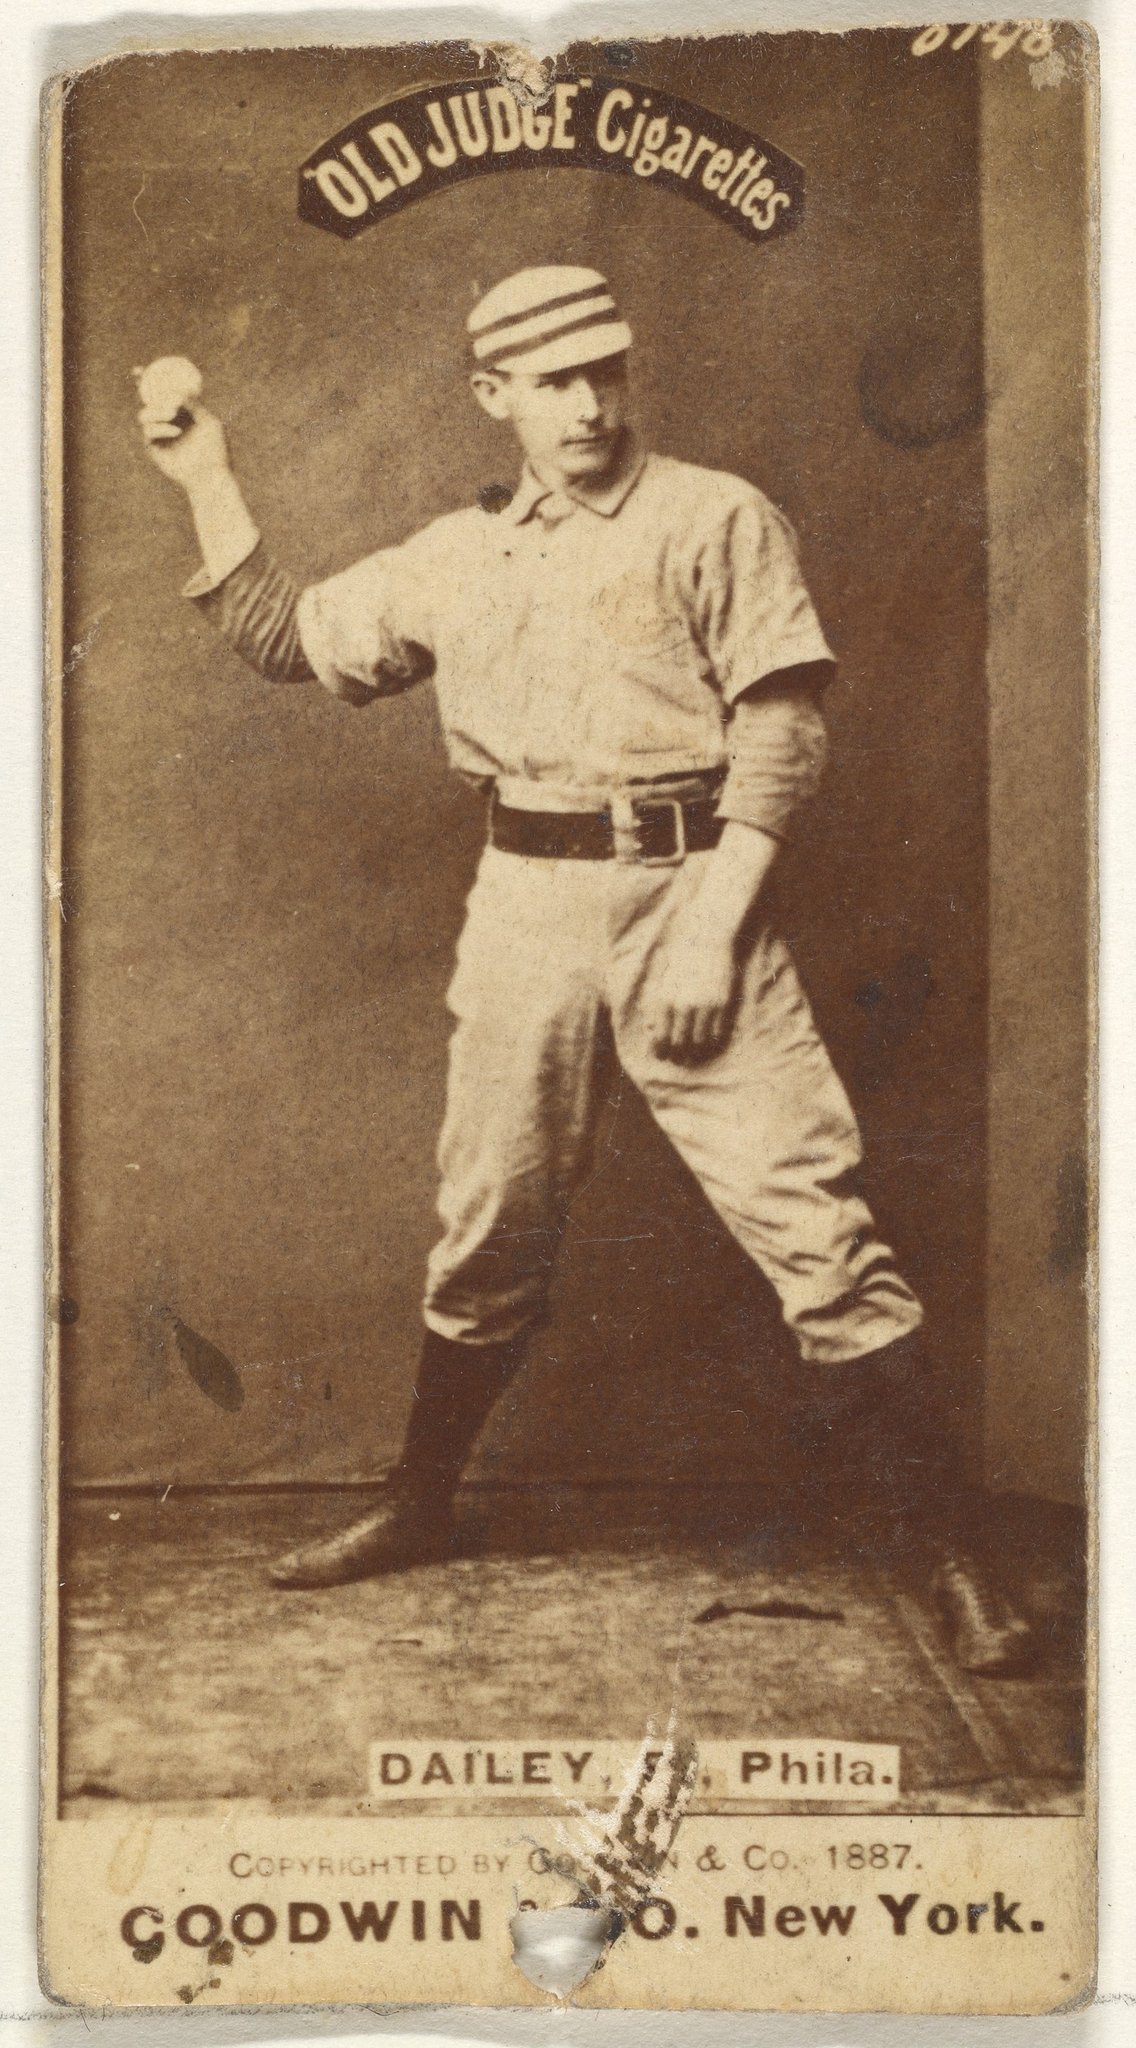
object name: baseball card, photograph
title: Edward M. Daily, Pitcher, Philadelphia, from the Old Judge series (N172) for Old Judge Cigarettes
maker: goodwin & company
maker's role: publisher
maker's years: 1850-1950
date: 1887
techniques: albumen silver print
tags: men,portraits,baseball,athletes